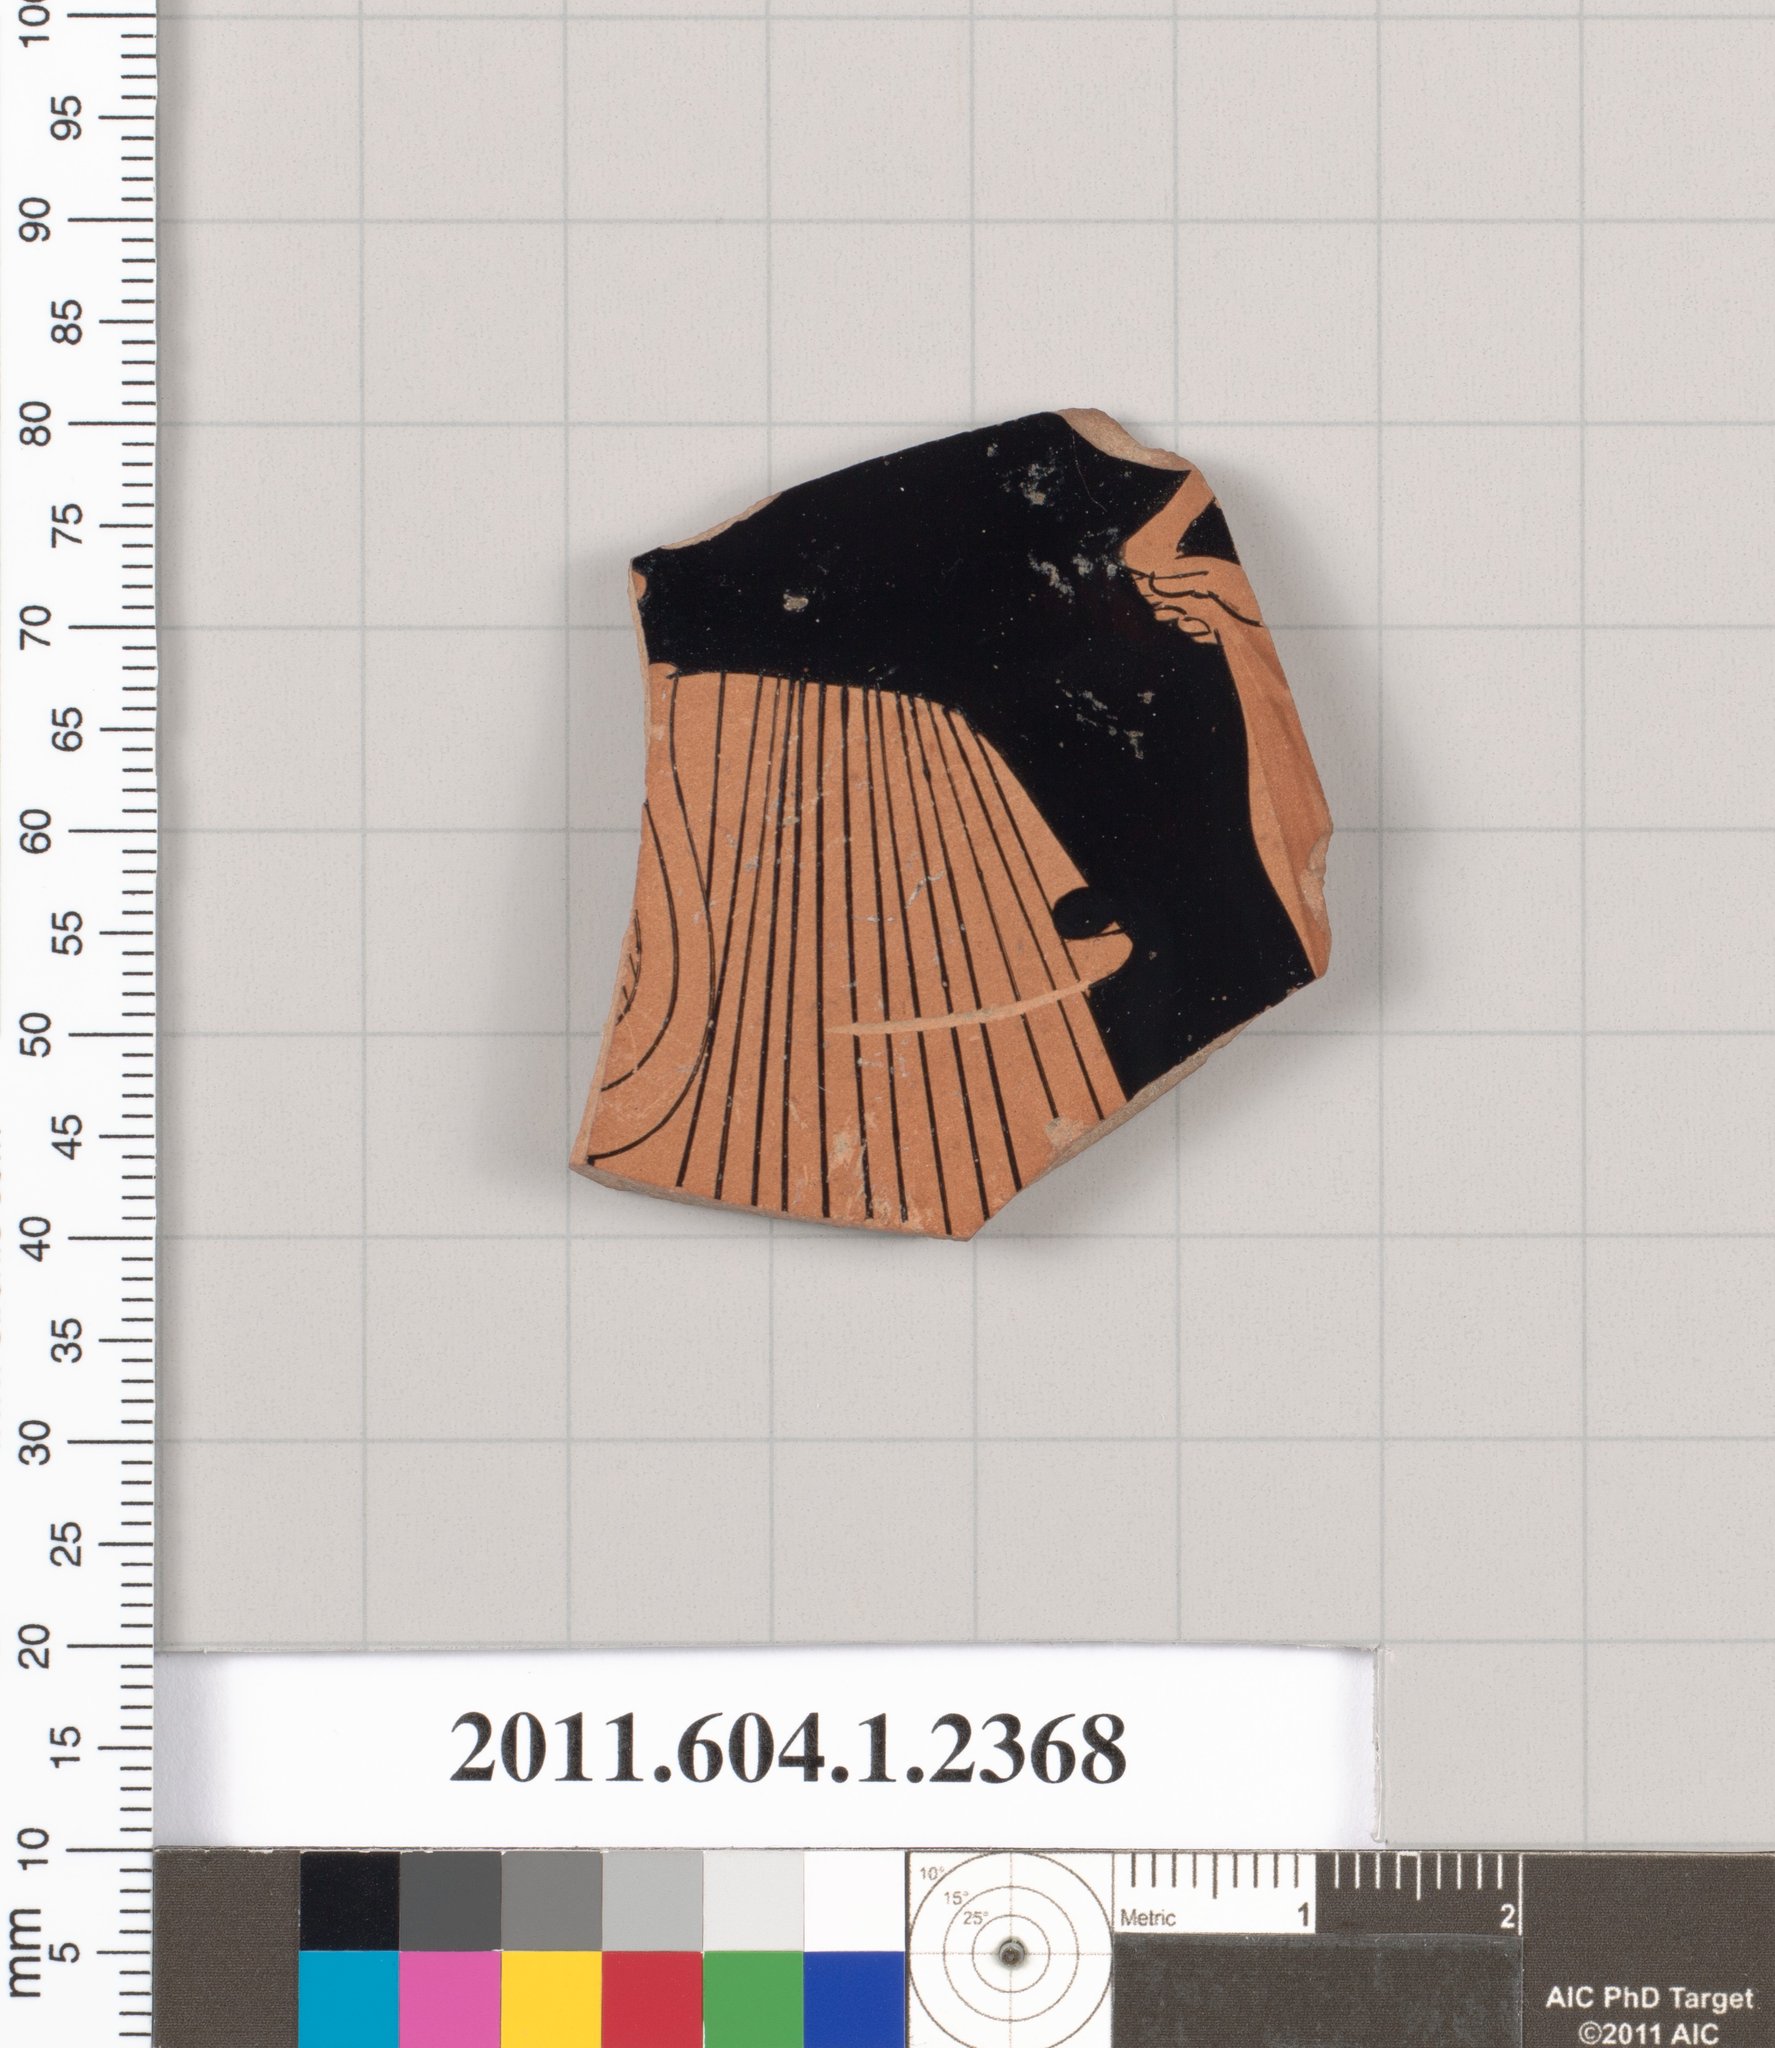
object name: kylix fragment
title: Terracotta fragment of a kylix (drinking cup)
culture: greek, attic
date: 500-476 BCE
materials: terracotta